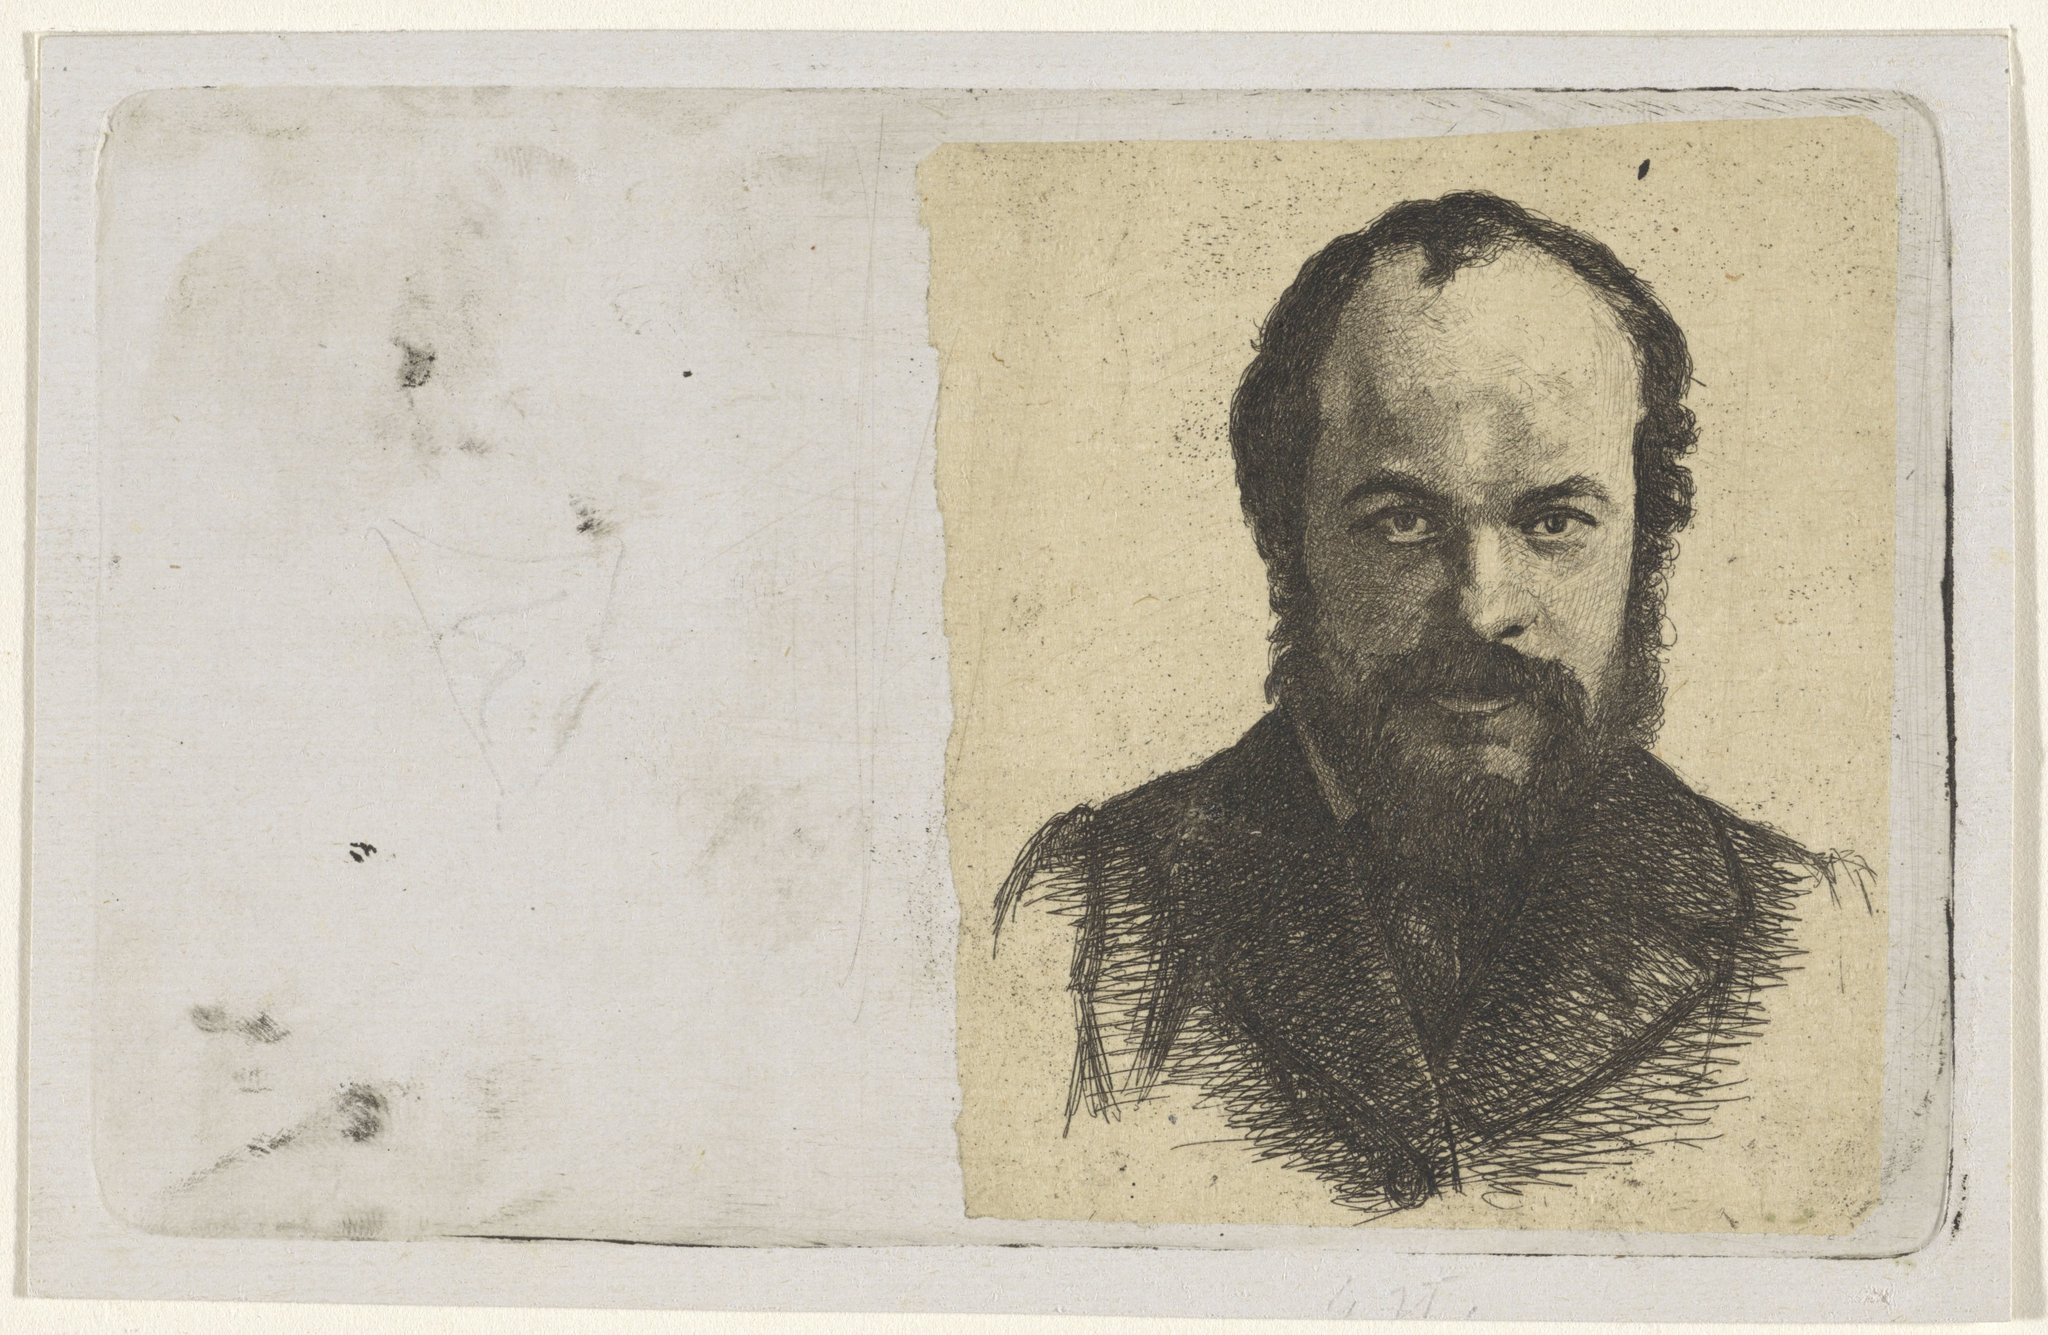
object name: print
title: Portret van Jan Weissenbruch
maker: frederik hendrik weissenbruch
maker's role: draughtsman, print maker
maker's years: 1828-1887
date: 1863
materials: paper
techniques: drypoint, etching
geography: the hague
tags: the hague, painter, print maker, jan weissenbruch, historical persons, portrait, self-portrait of artist, beard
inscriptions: collector's mark: Lugt 2228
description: Portret van de kunstenaar Jan Weissenbruch, oudere broer en leermeester van de vervaardigend kunstenaar.